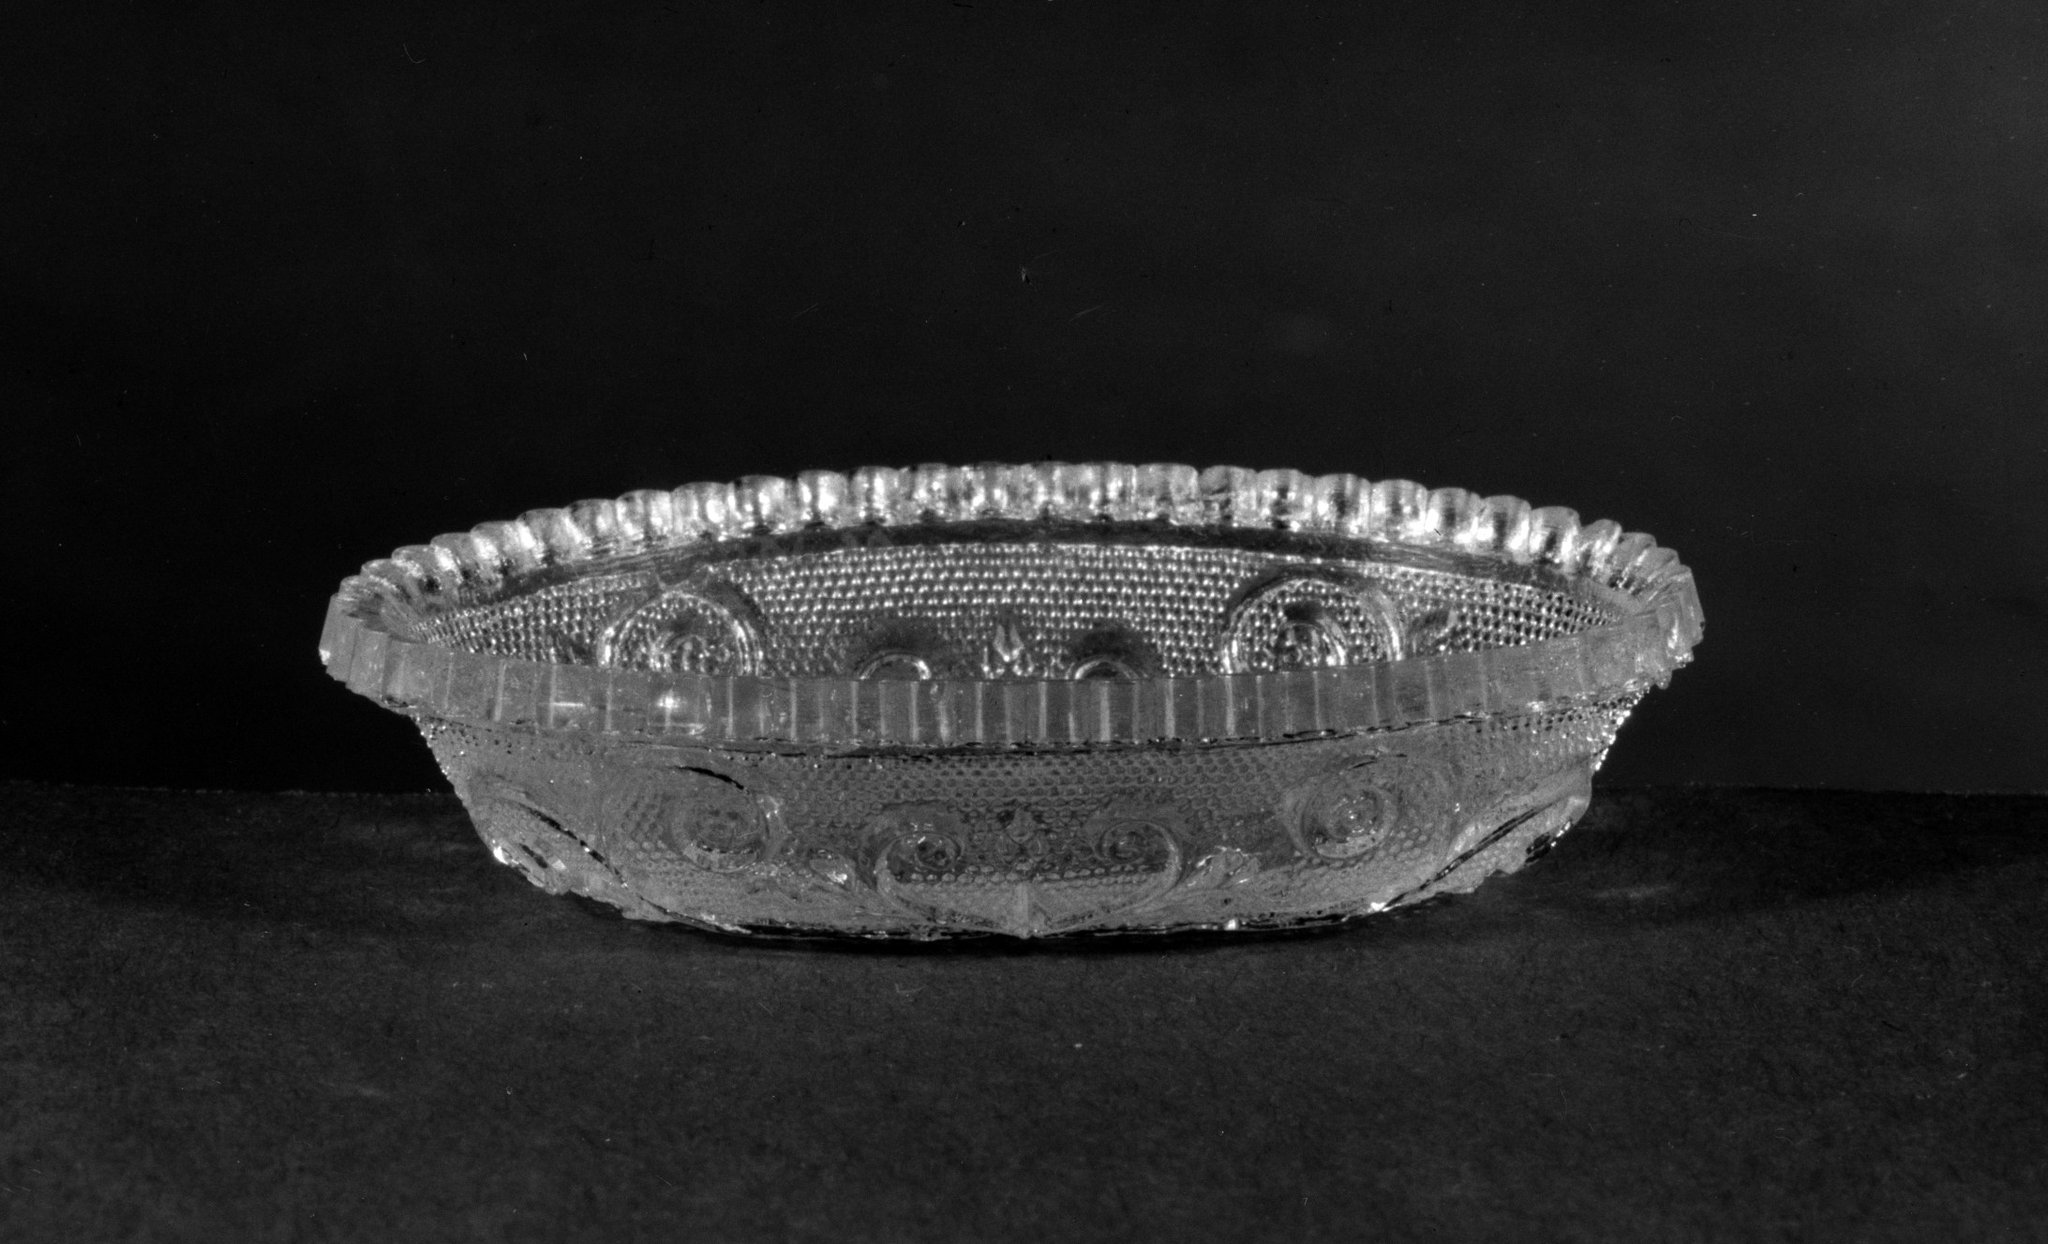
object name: dish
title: Miniature Dish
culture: american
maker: boston & sandwich glass company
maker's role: maker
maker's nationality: american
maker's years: 1825-1888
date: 1835-1850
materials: glass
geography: united states